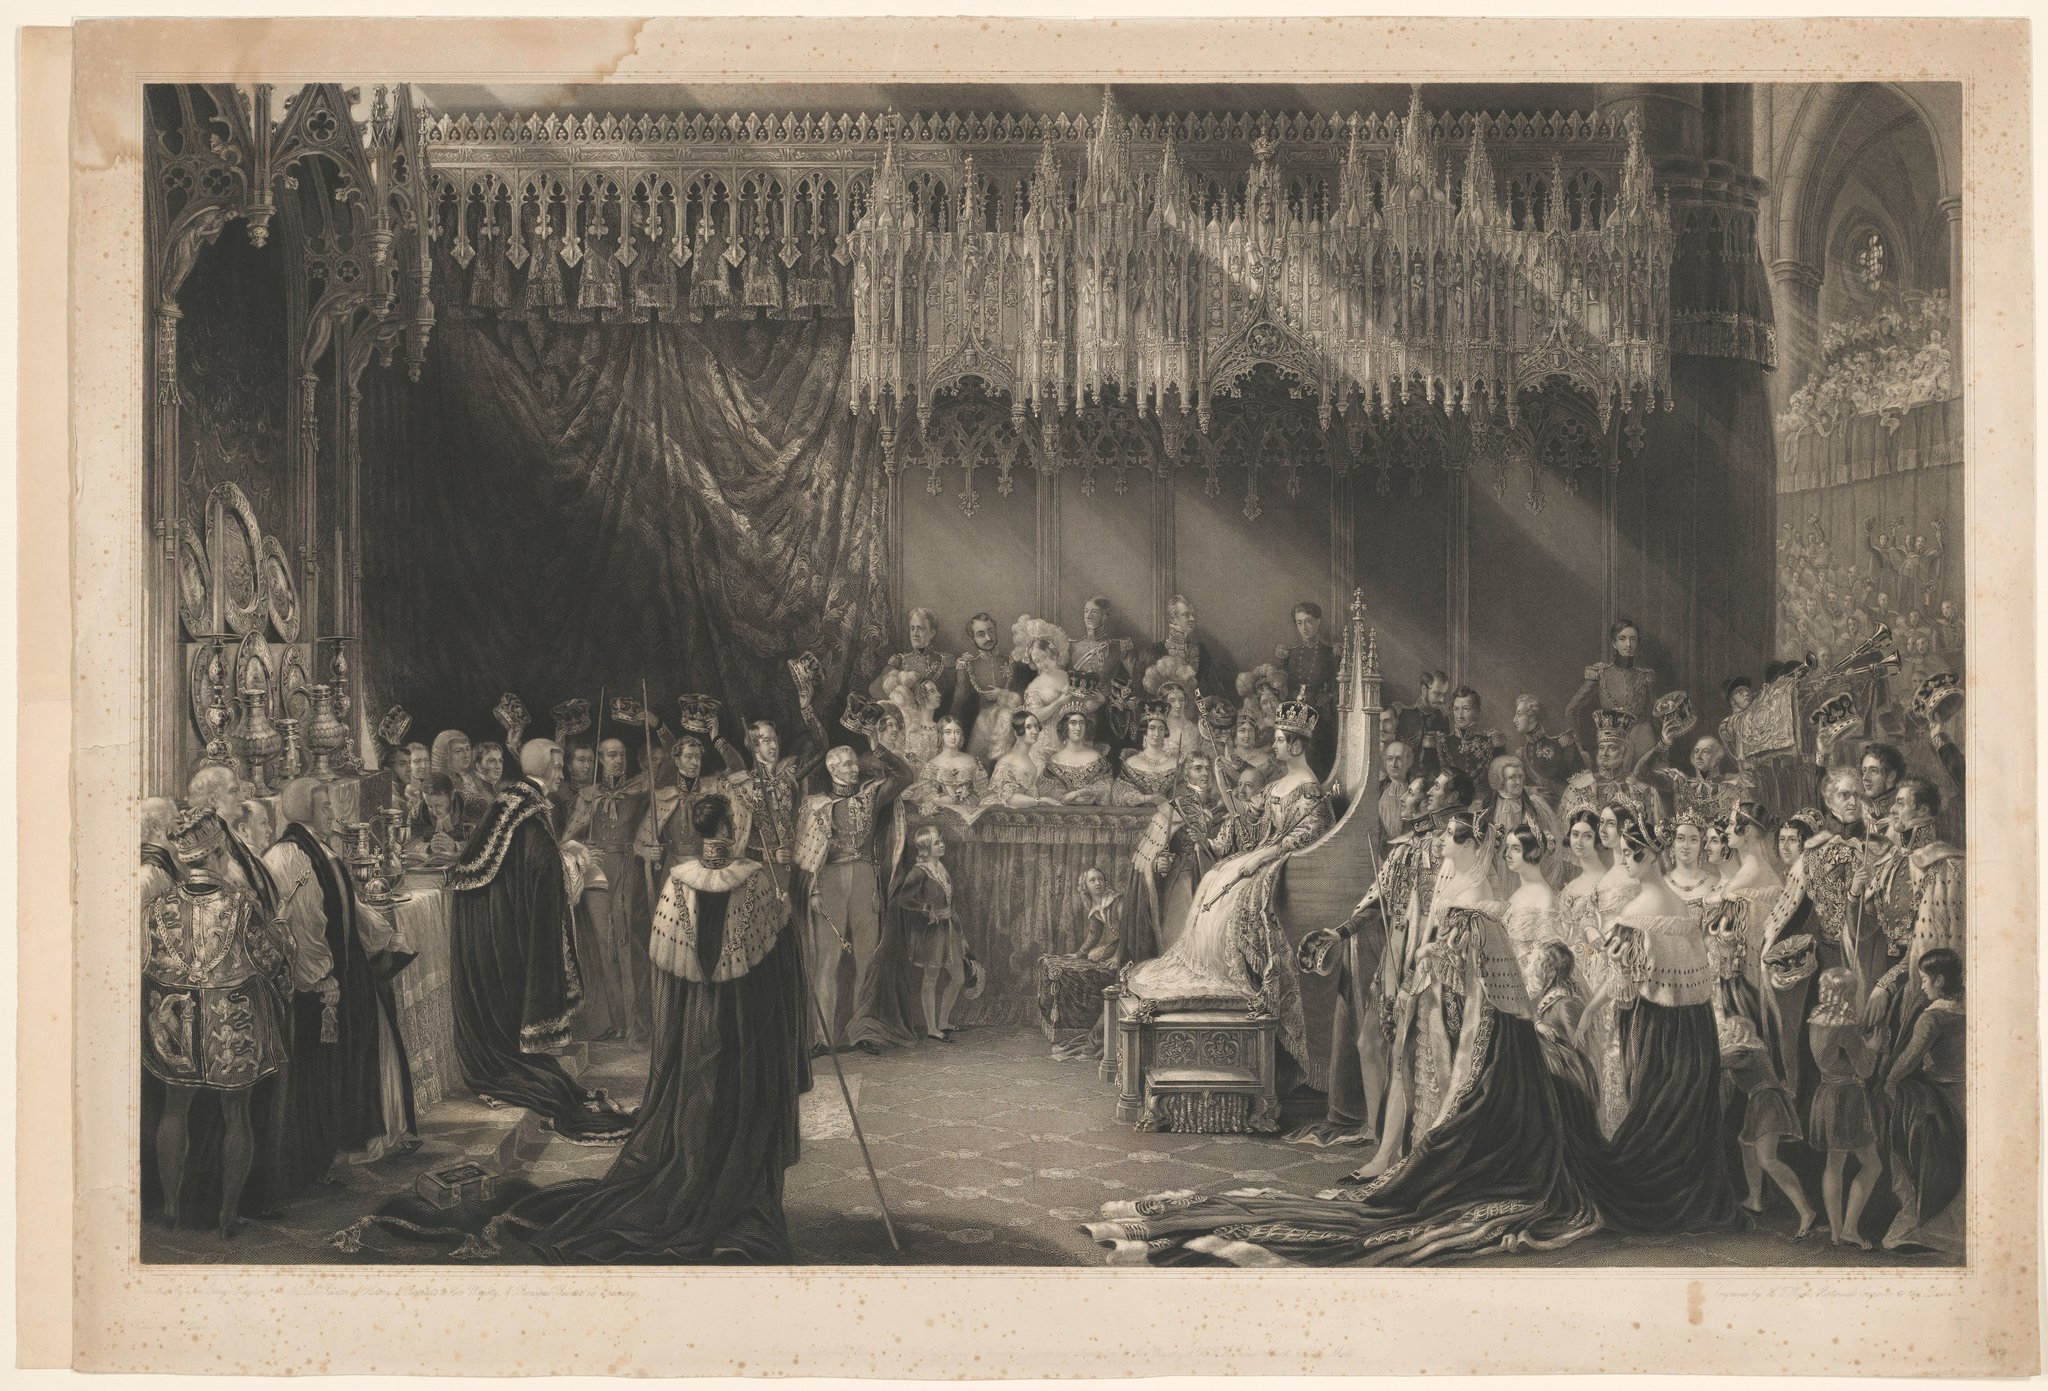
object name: print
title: Kroning van Victoria, koningin van het Verenigd Koninkrijk en keizerin van India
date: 1819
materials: paper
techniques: etching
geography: england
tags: victoria (koningin van het verenigd koninkrijk en keizerin van india), coronation of a ruler - bb - female ruler, westminster abbey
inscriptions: collector's mark: Lugt 2228